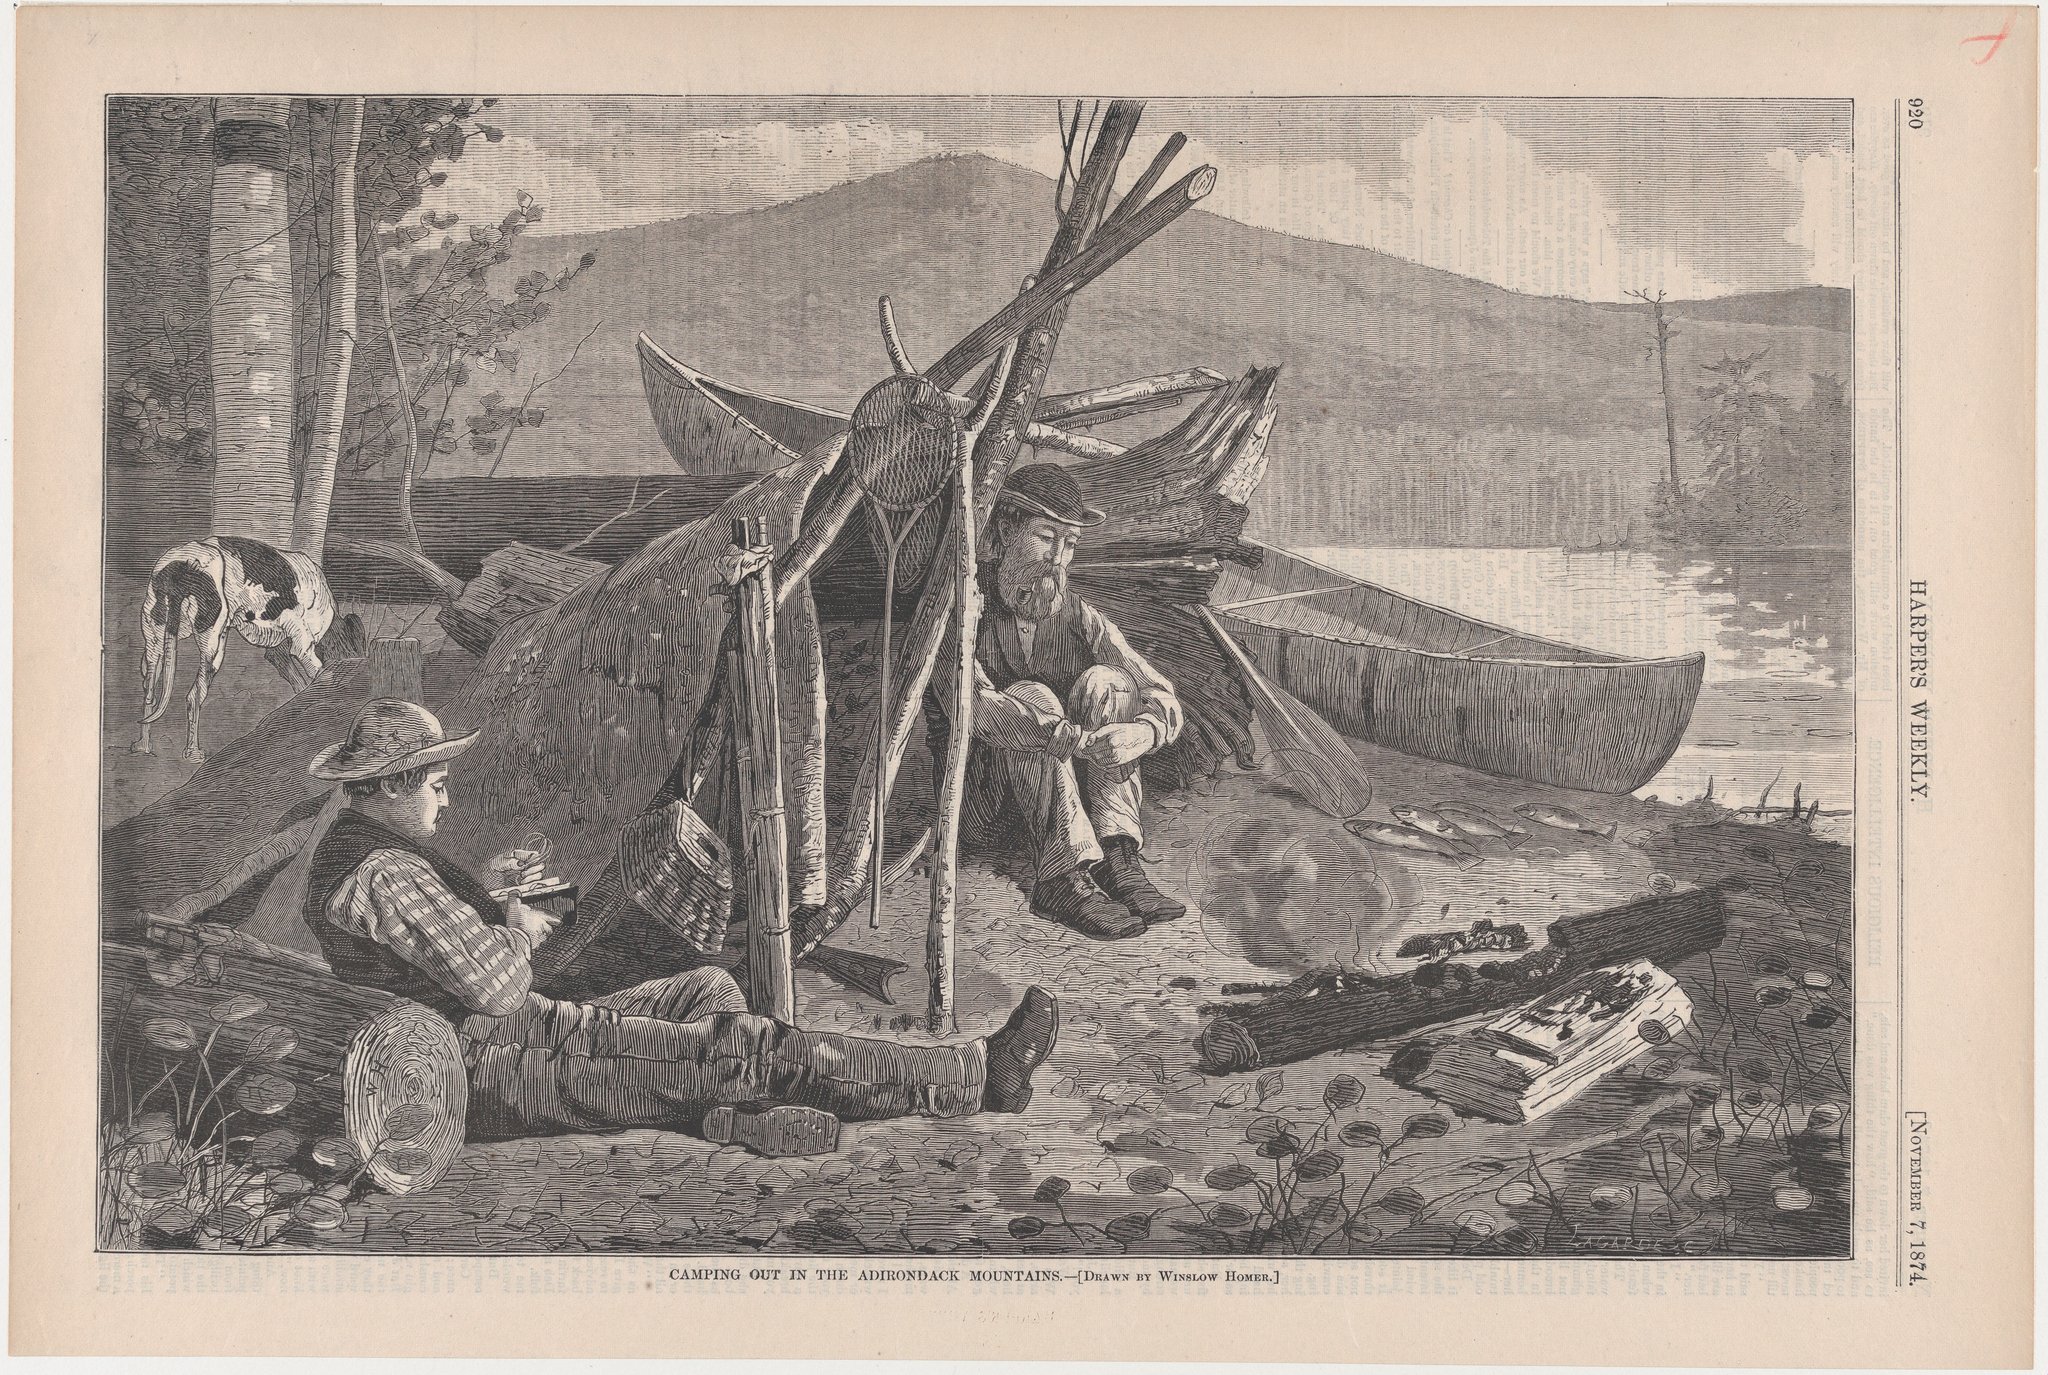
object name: print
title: Camping Out in Adirondacks (from "Harper's Weekly," Vol. XVIII)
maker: winslow homer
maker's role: artist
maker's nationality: american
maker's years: 1836-1910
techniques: engraving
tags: tents,men,dogs,boats